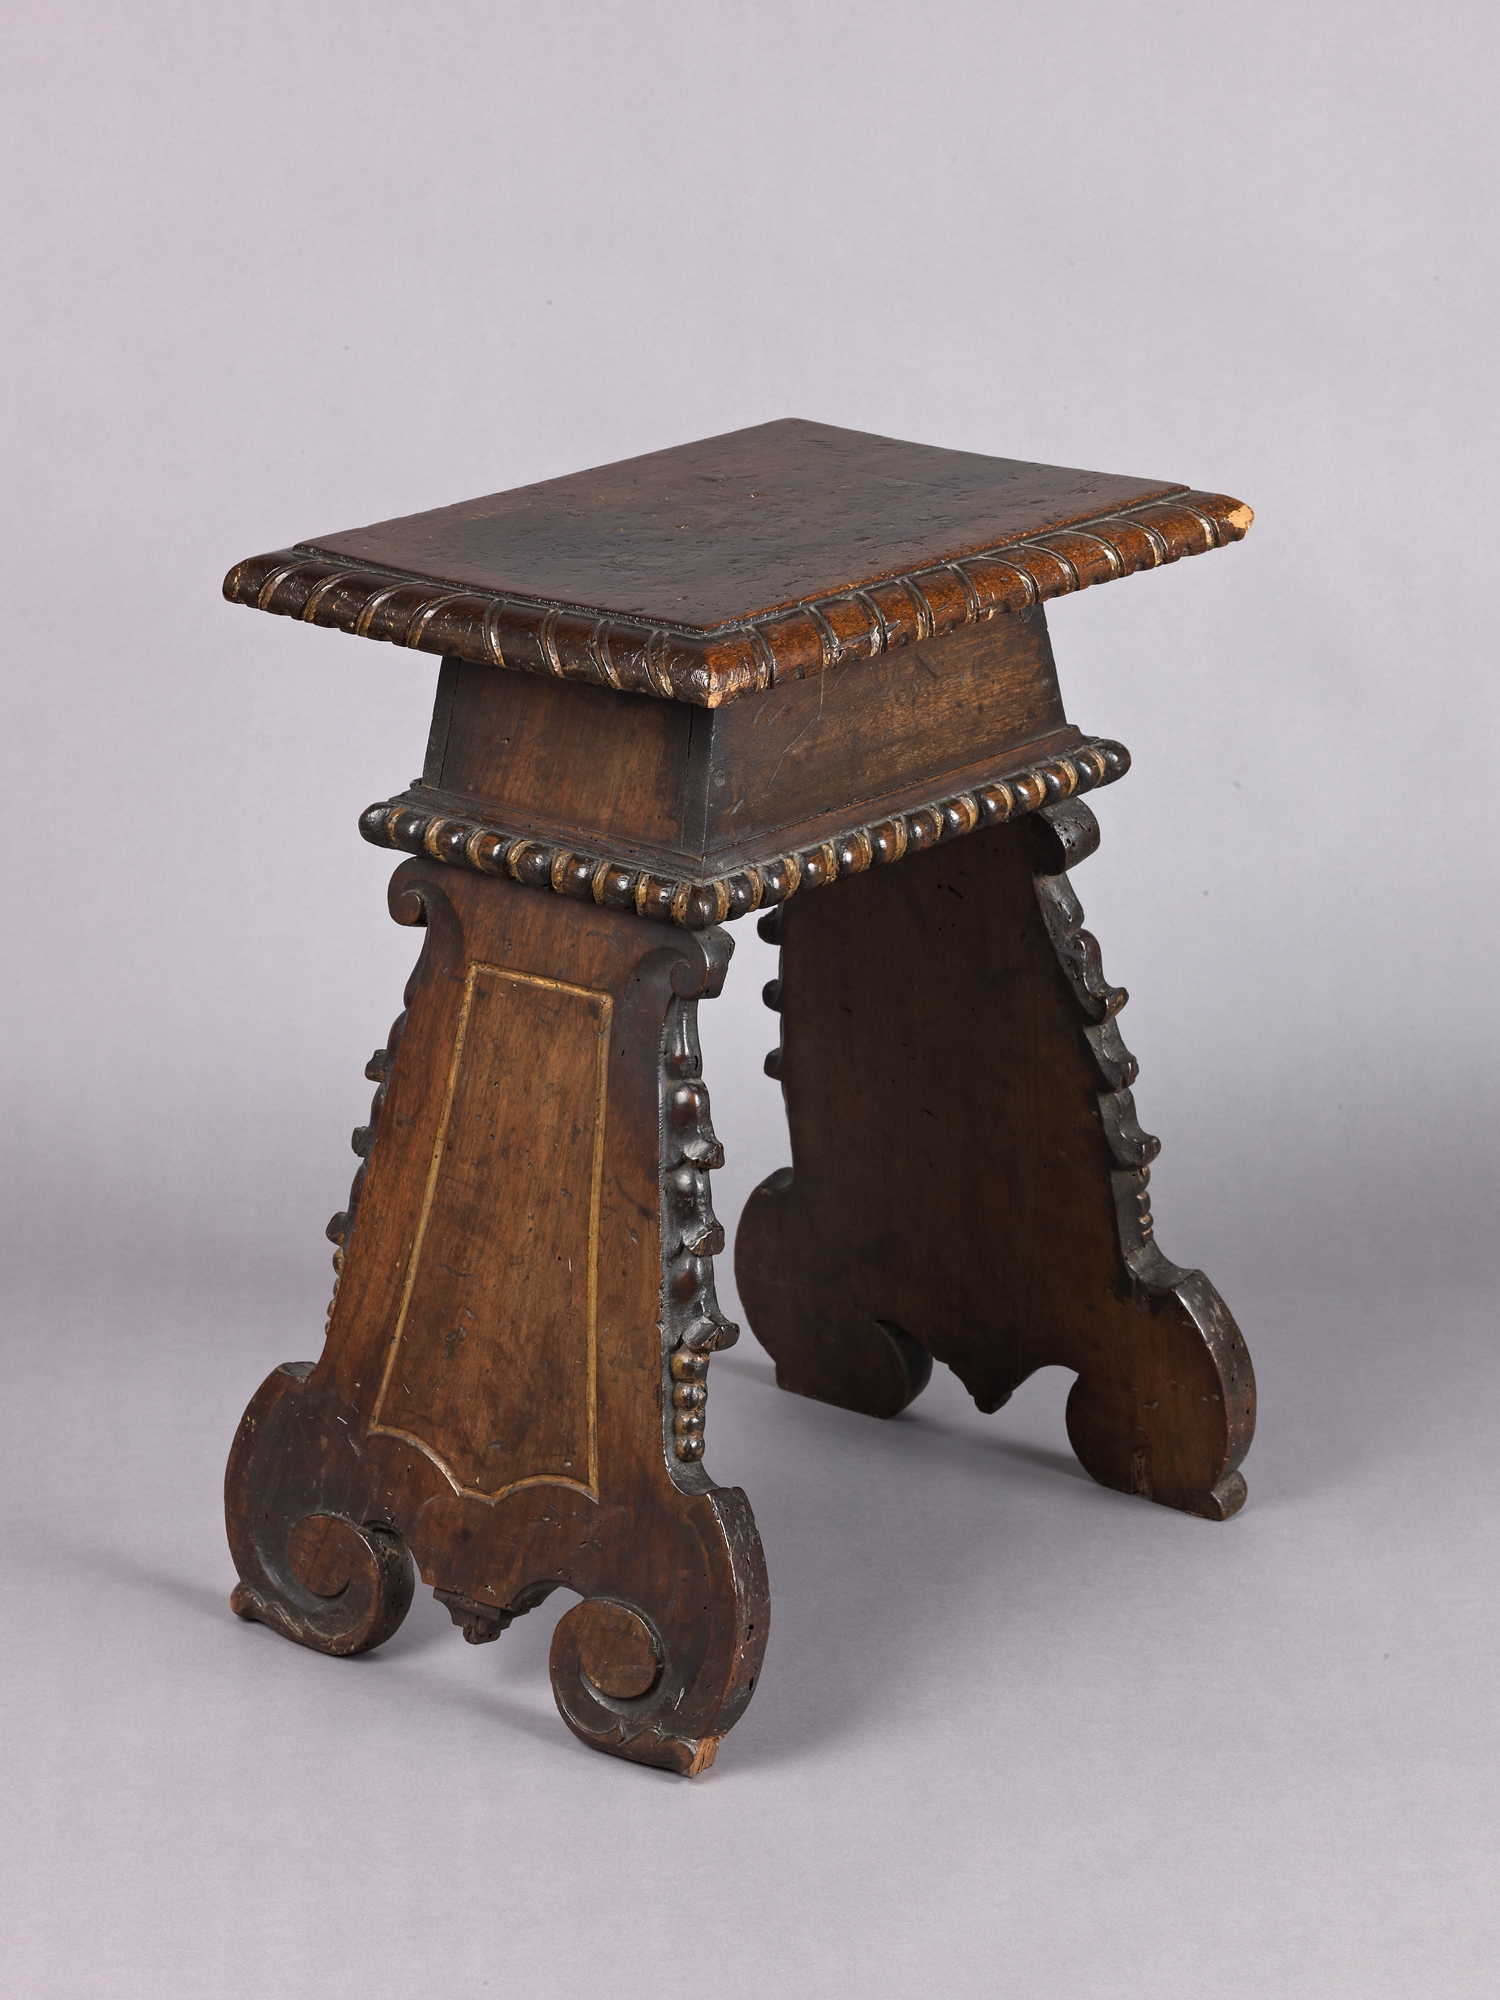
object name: stool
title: Stool (pair with 1975.1.2003)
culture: italian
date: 1501-1600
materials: wood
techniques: carving, gilding